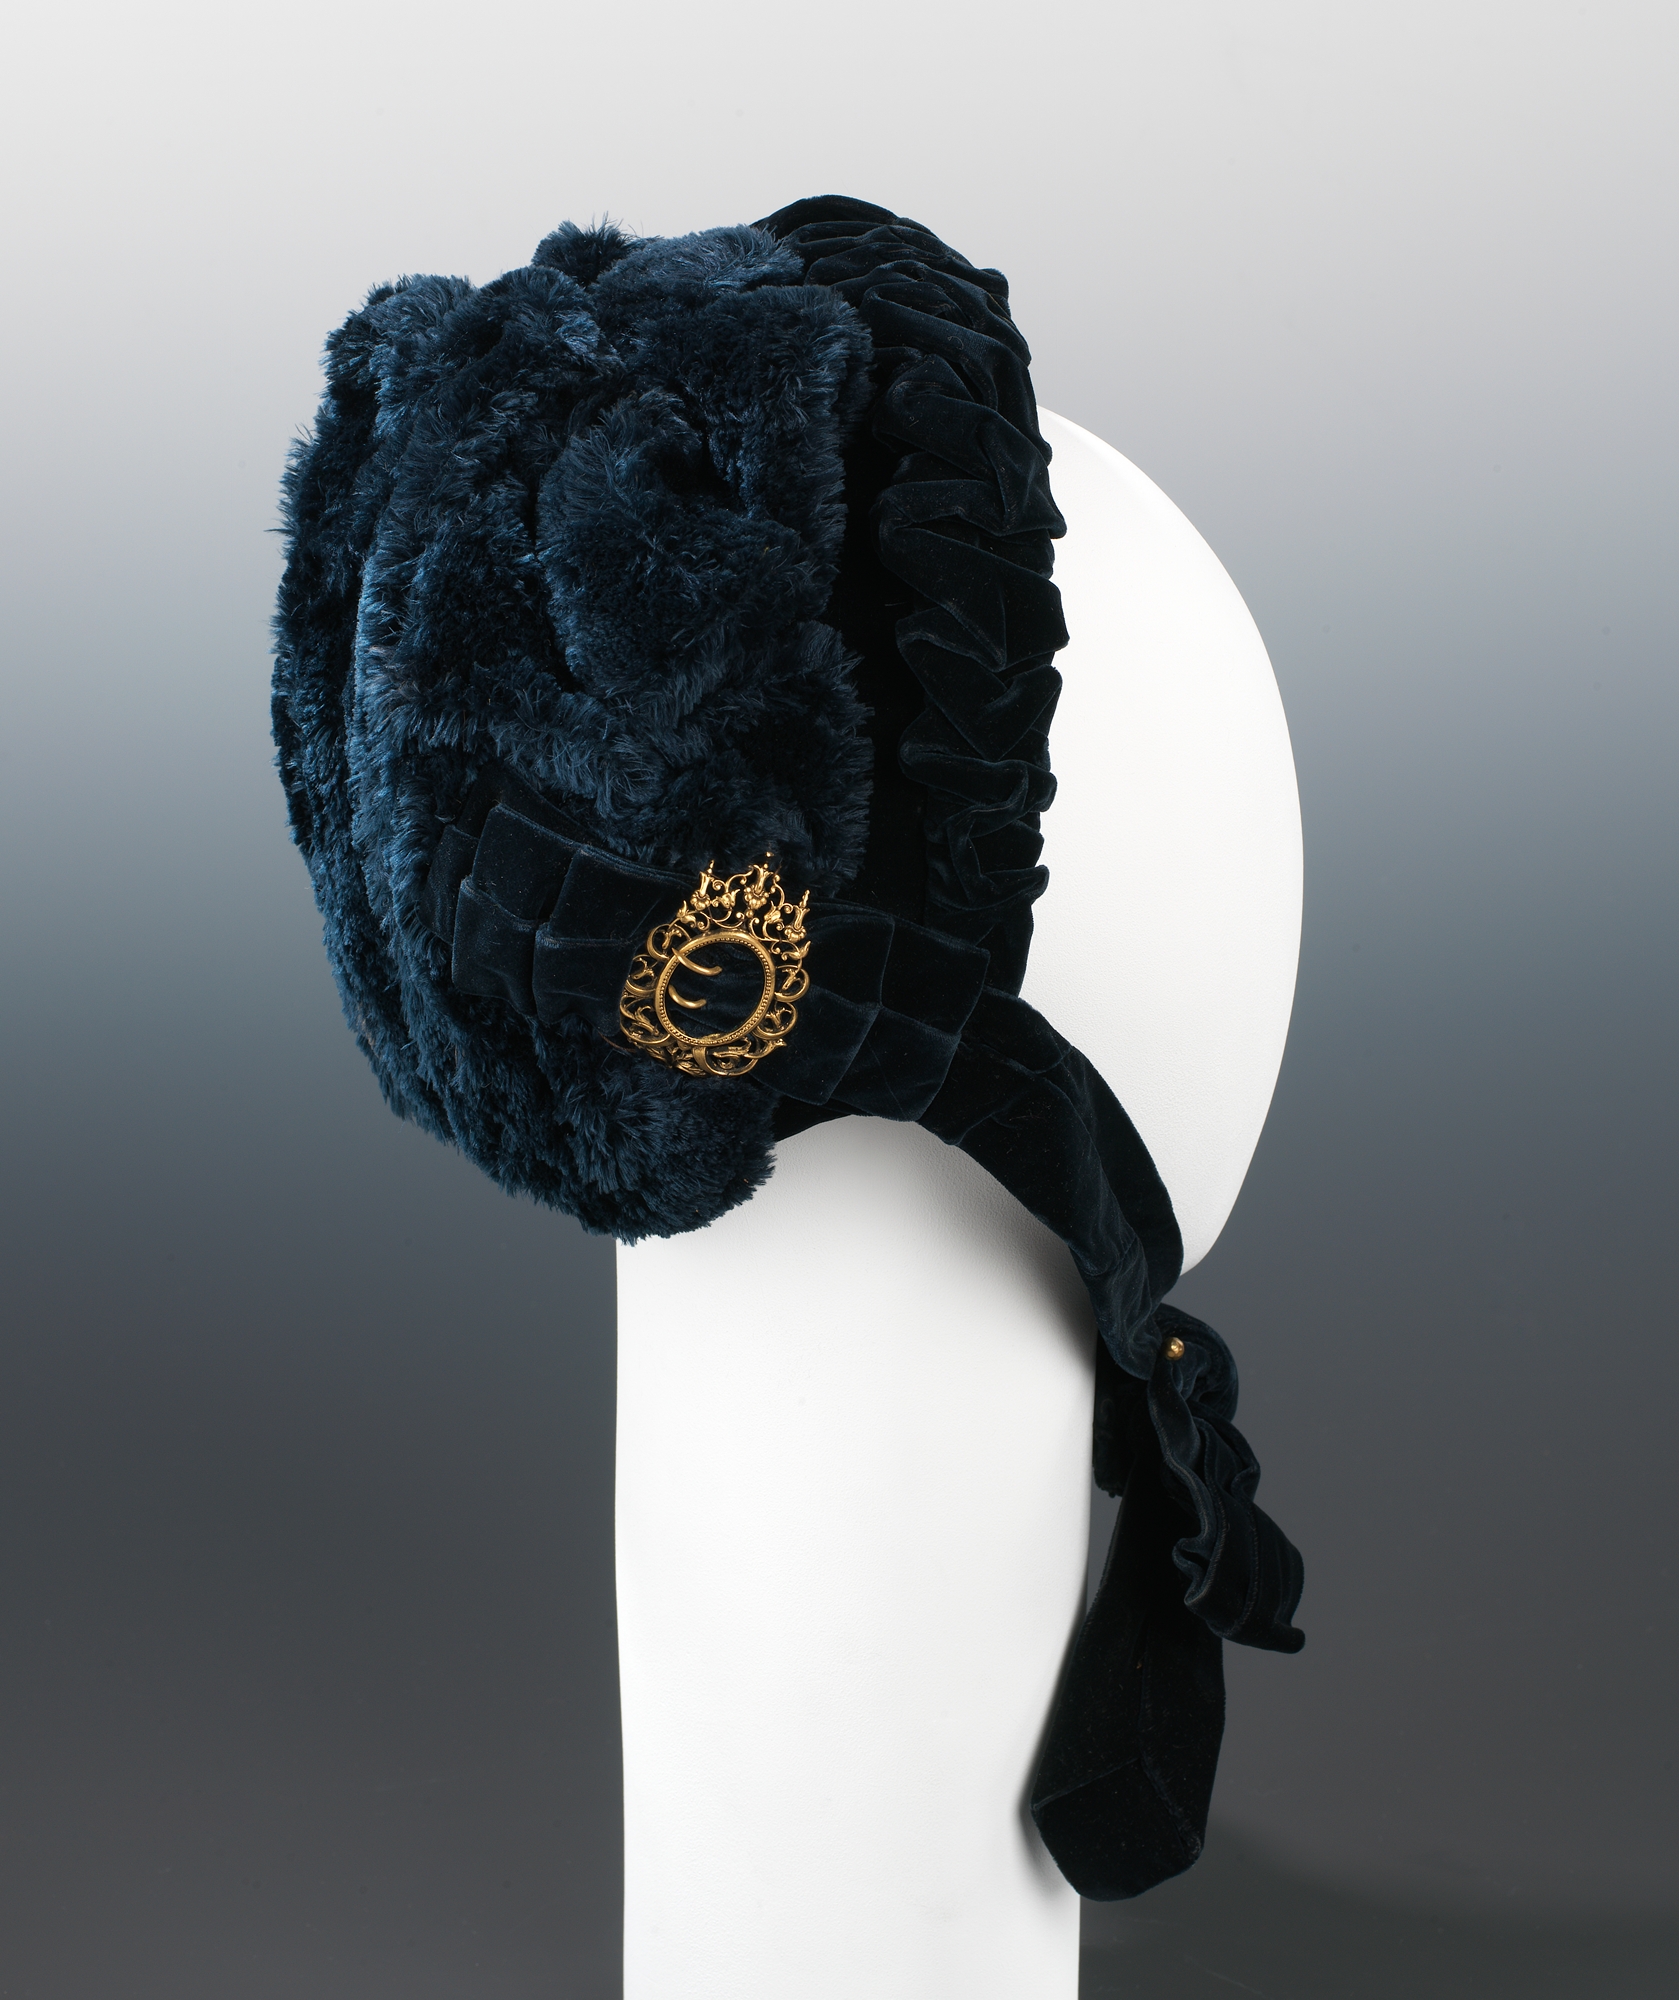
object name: bonnet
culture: french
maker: madame henry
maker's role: designer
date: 1882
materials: metal, silk